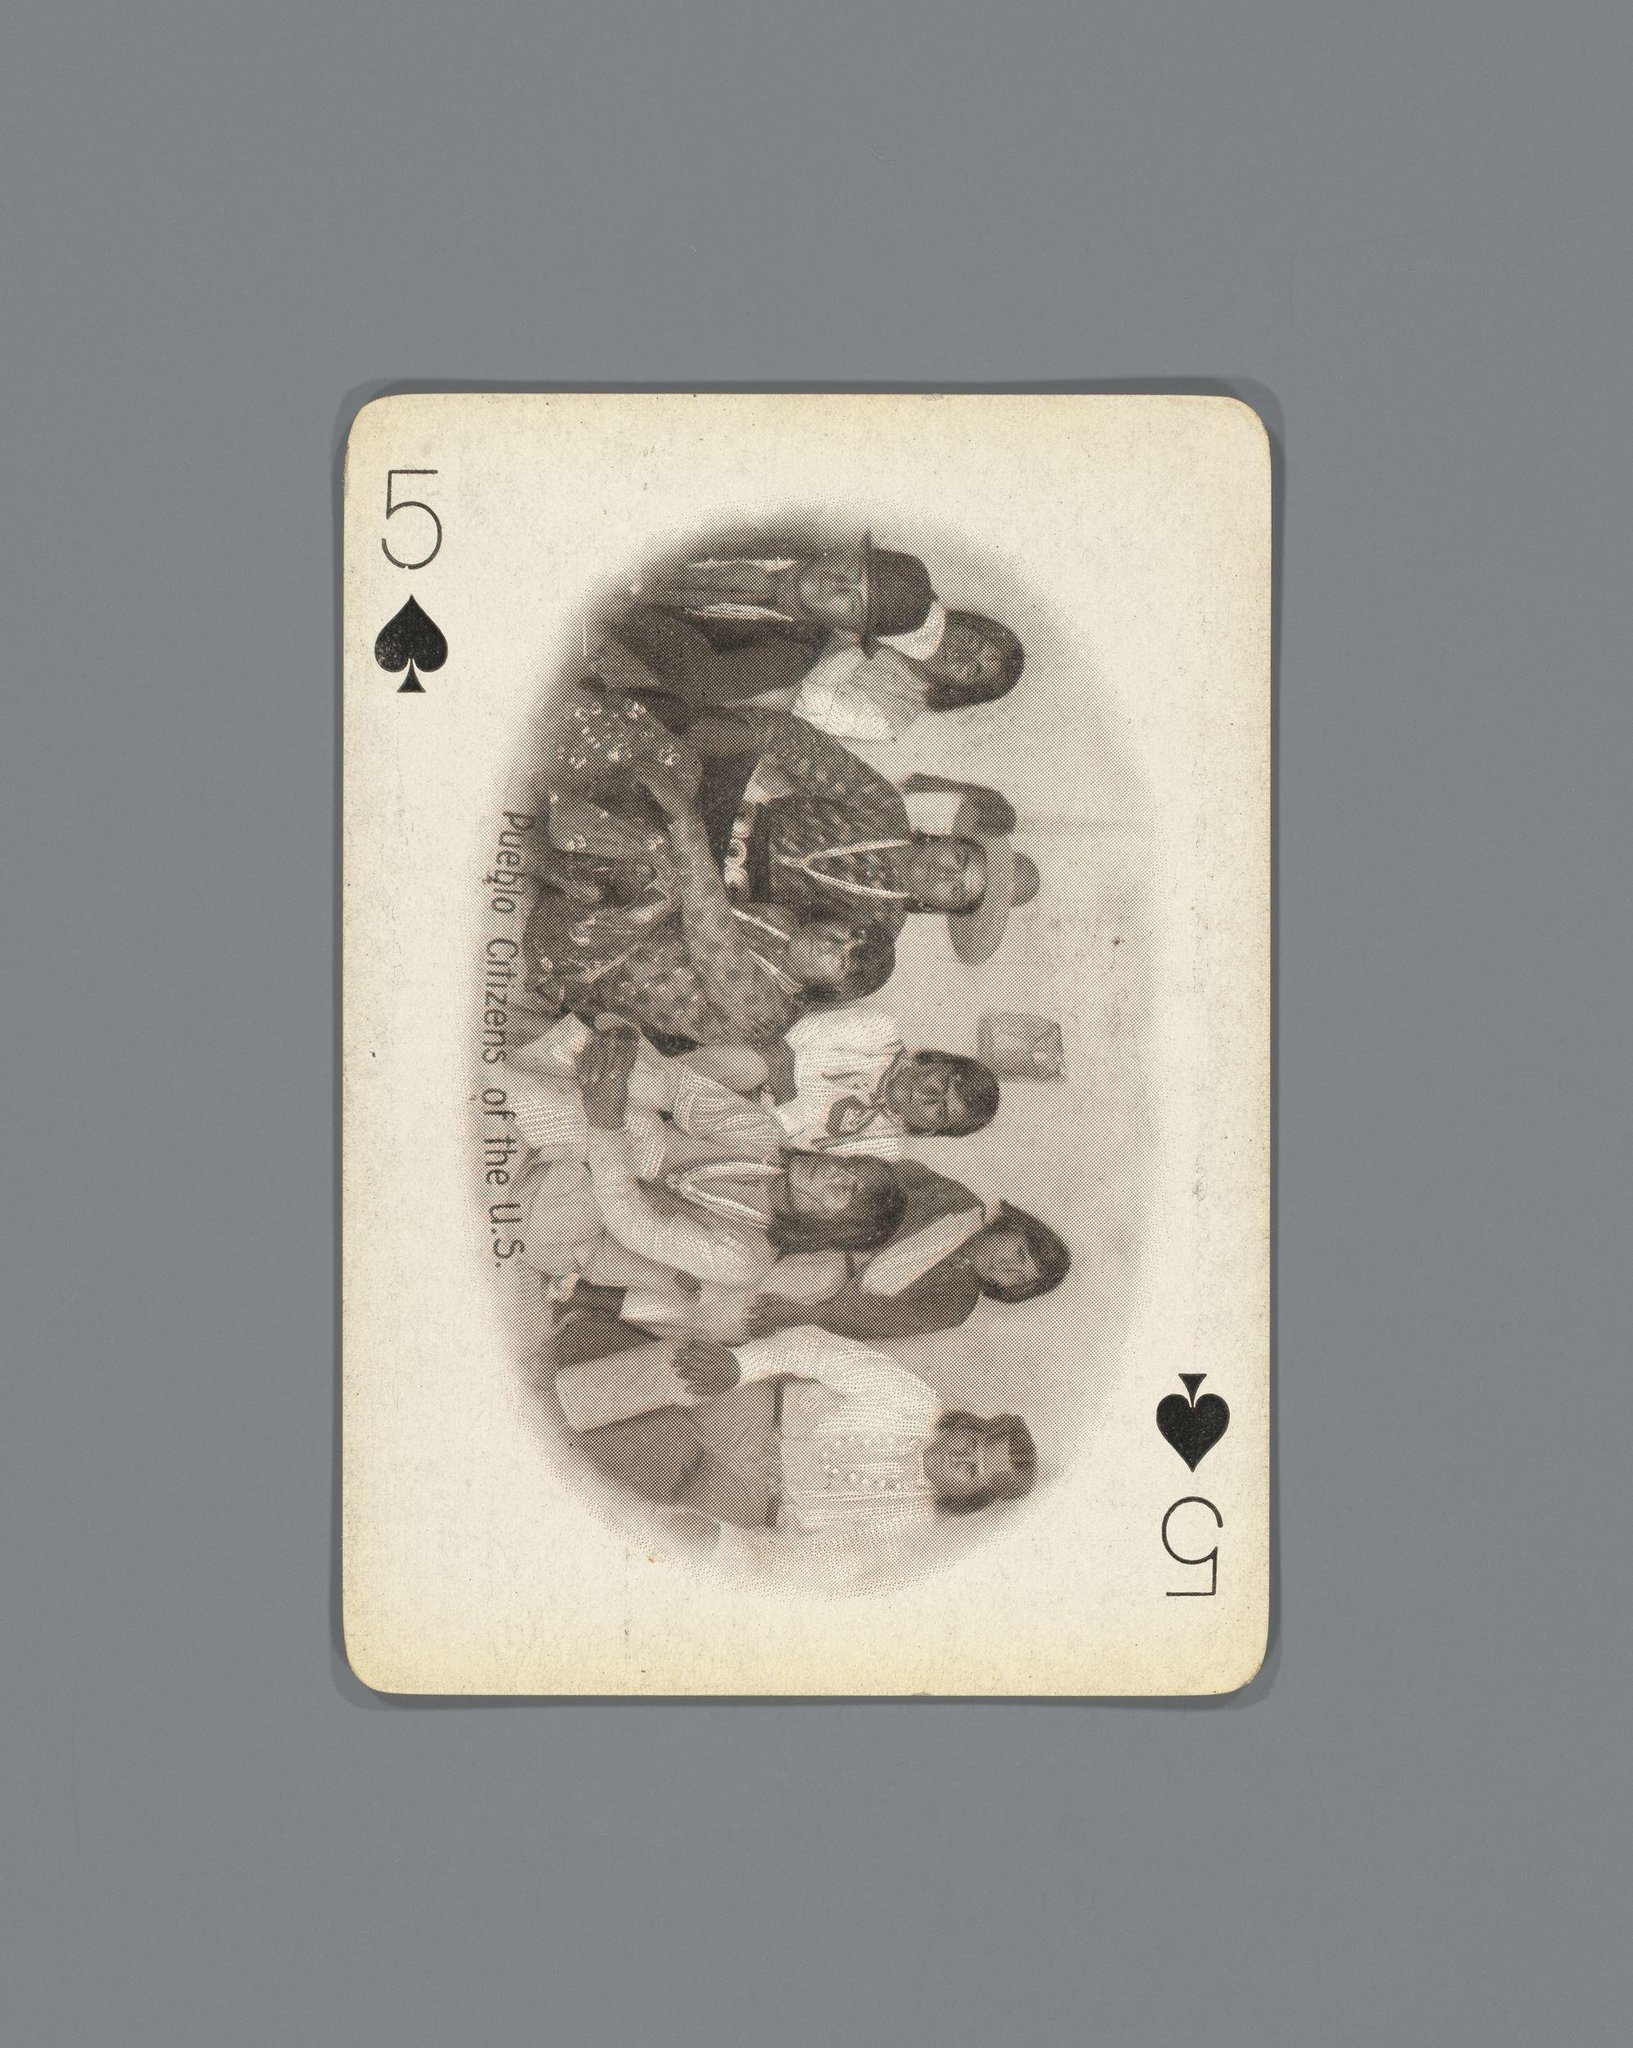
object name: playing card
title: Schoppen vijf met groepsportret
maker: adam clark vroman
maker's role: fotograaf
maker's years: 1856-1916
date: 1900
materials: paper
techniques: autotype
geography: los angeles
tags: united states of america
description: Speelkaart uit doosje met 53 speelkaarten met afbeeldingen in autotypie van Native Americans. De inhoud bevat een complete set speelkaarten inclusief joker.